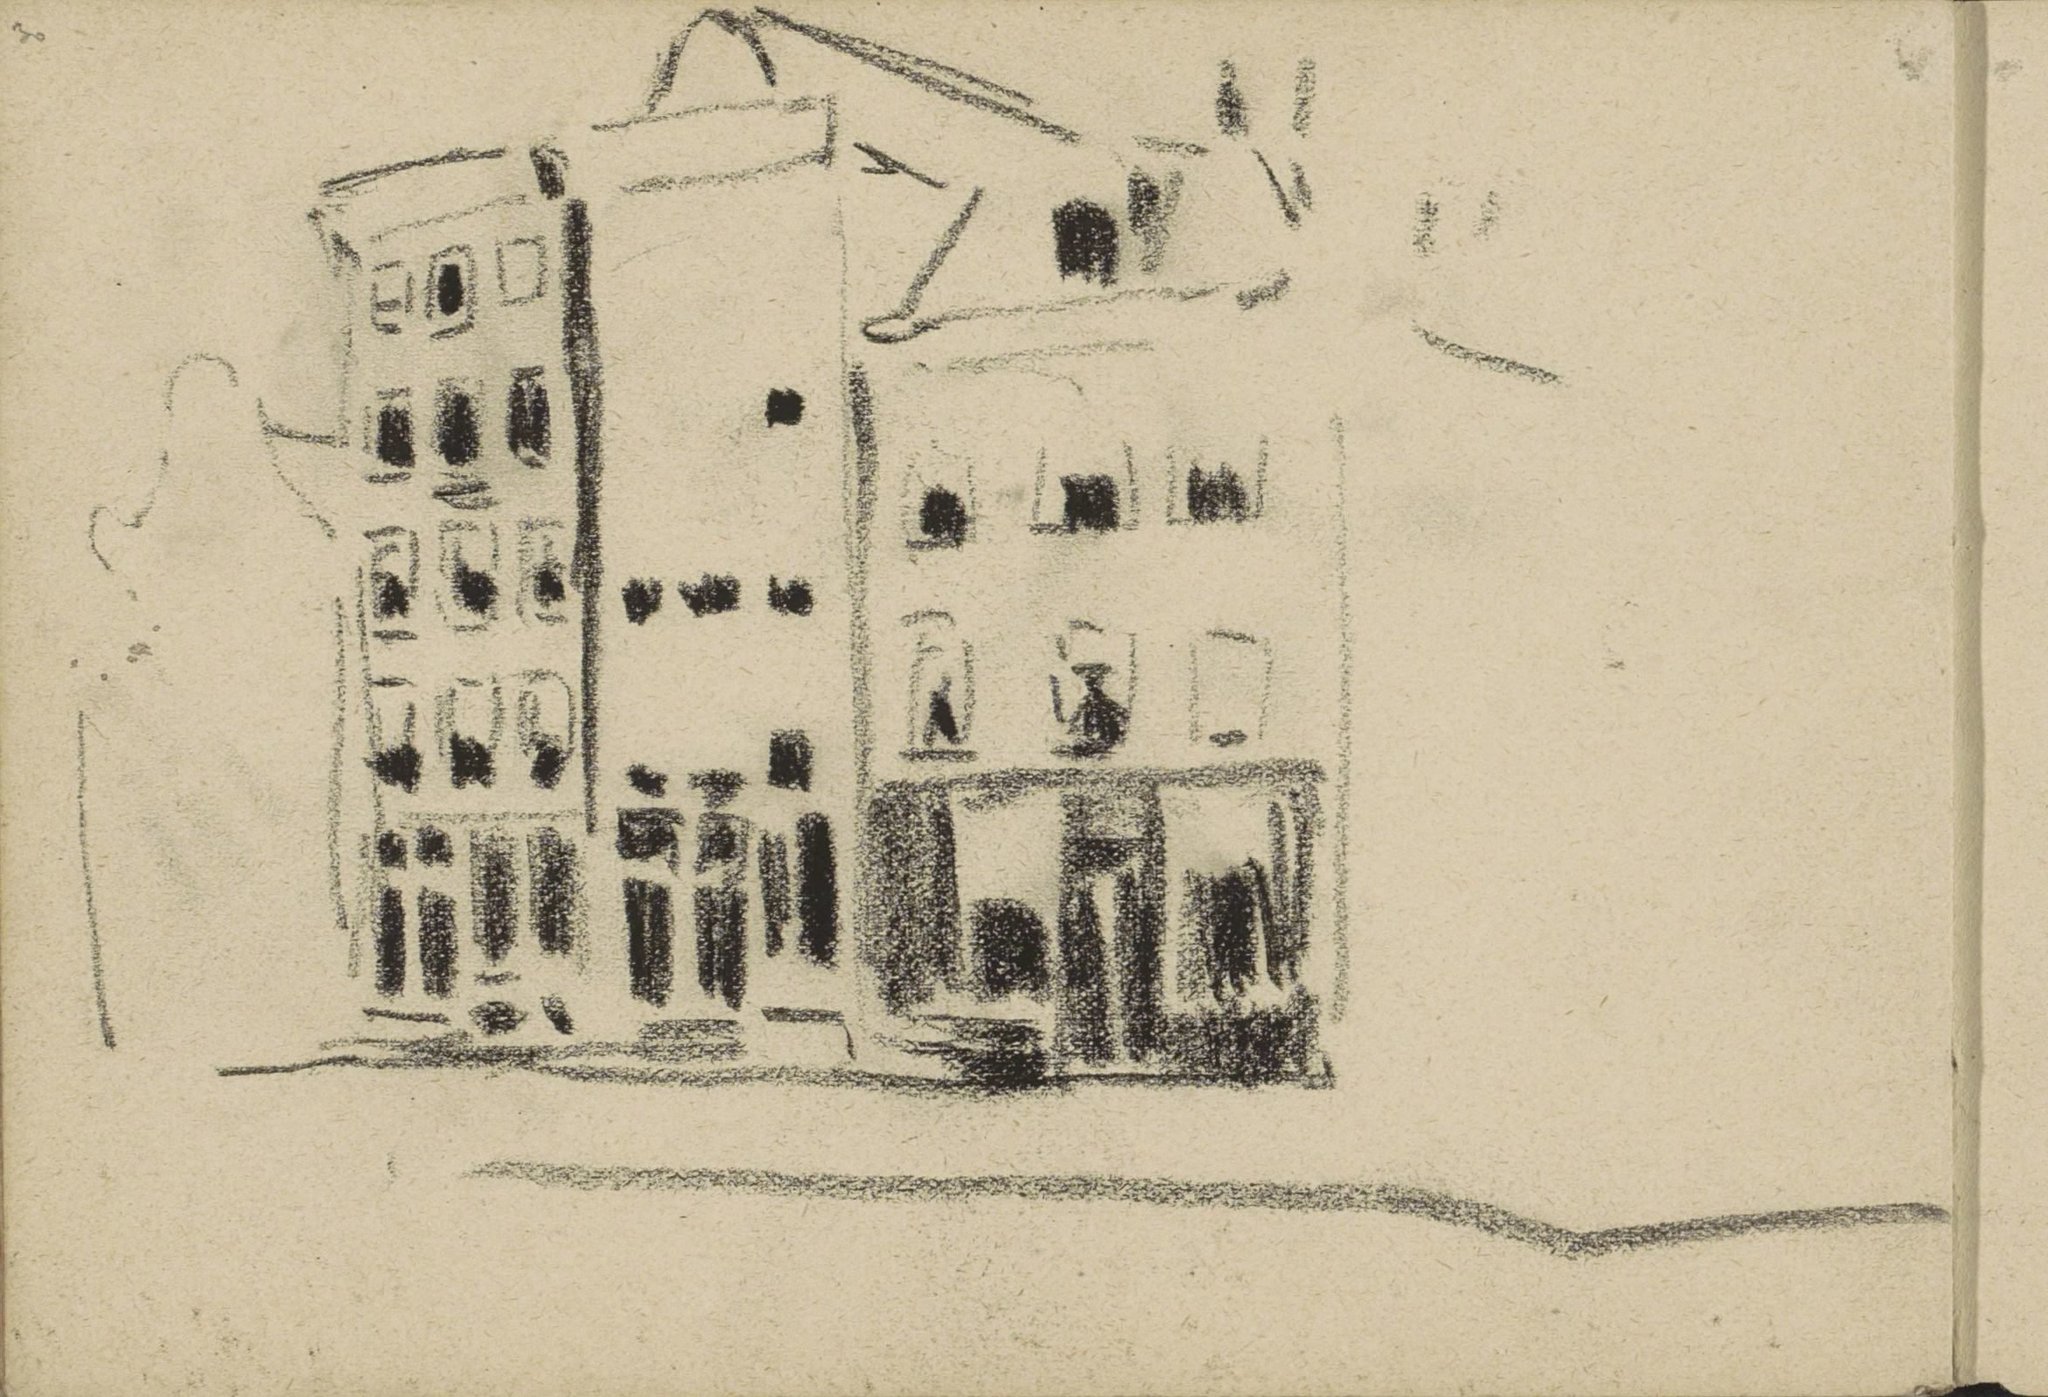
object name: sketchbook leaf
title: Huizenrij in Amsterdam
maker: willem witsen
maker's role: draughtsman, painter, print maker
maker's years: 1860-1923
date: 1870-1923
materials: chalk, paper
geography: amsterdam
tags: urban housing, amsterdam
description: Pagina 30 uit een schetsboek met 16 bladen.